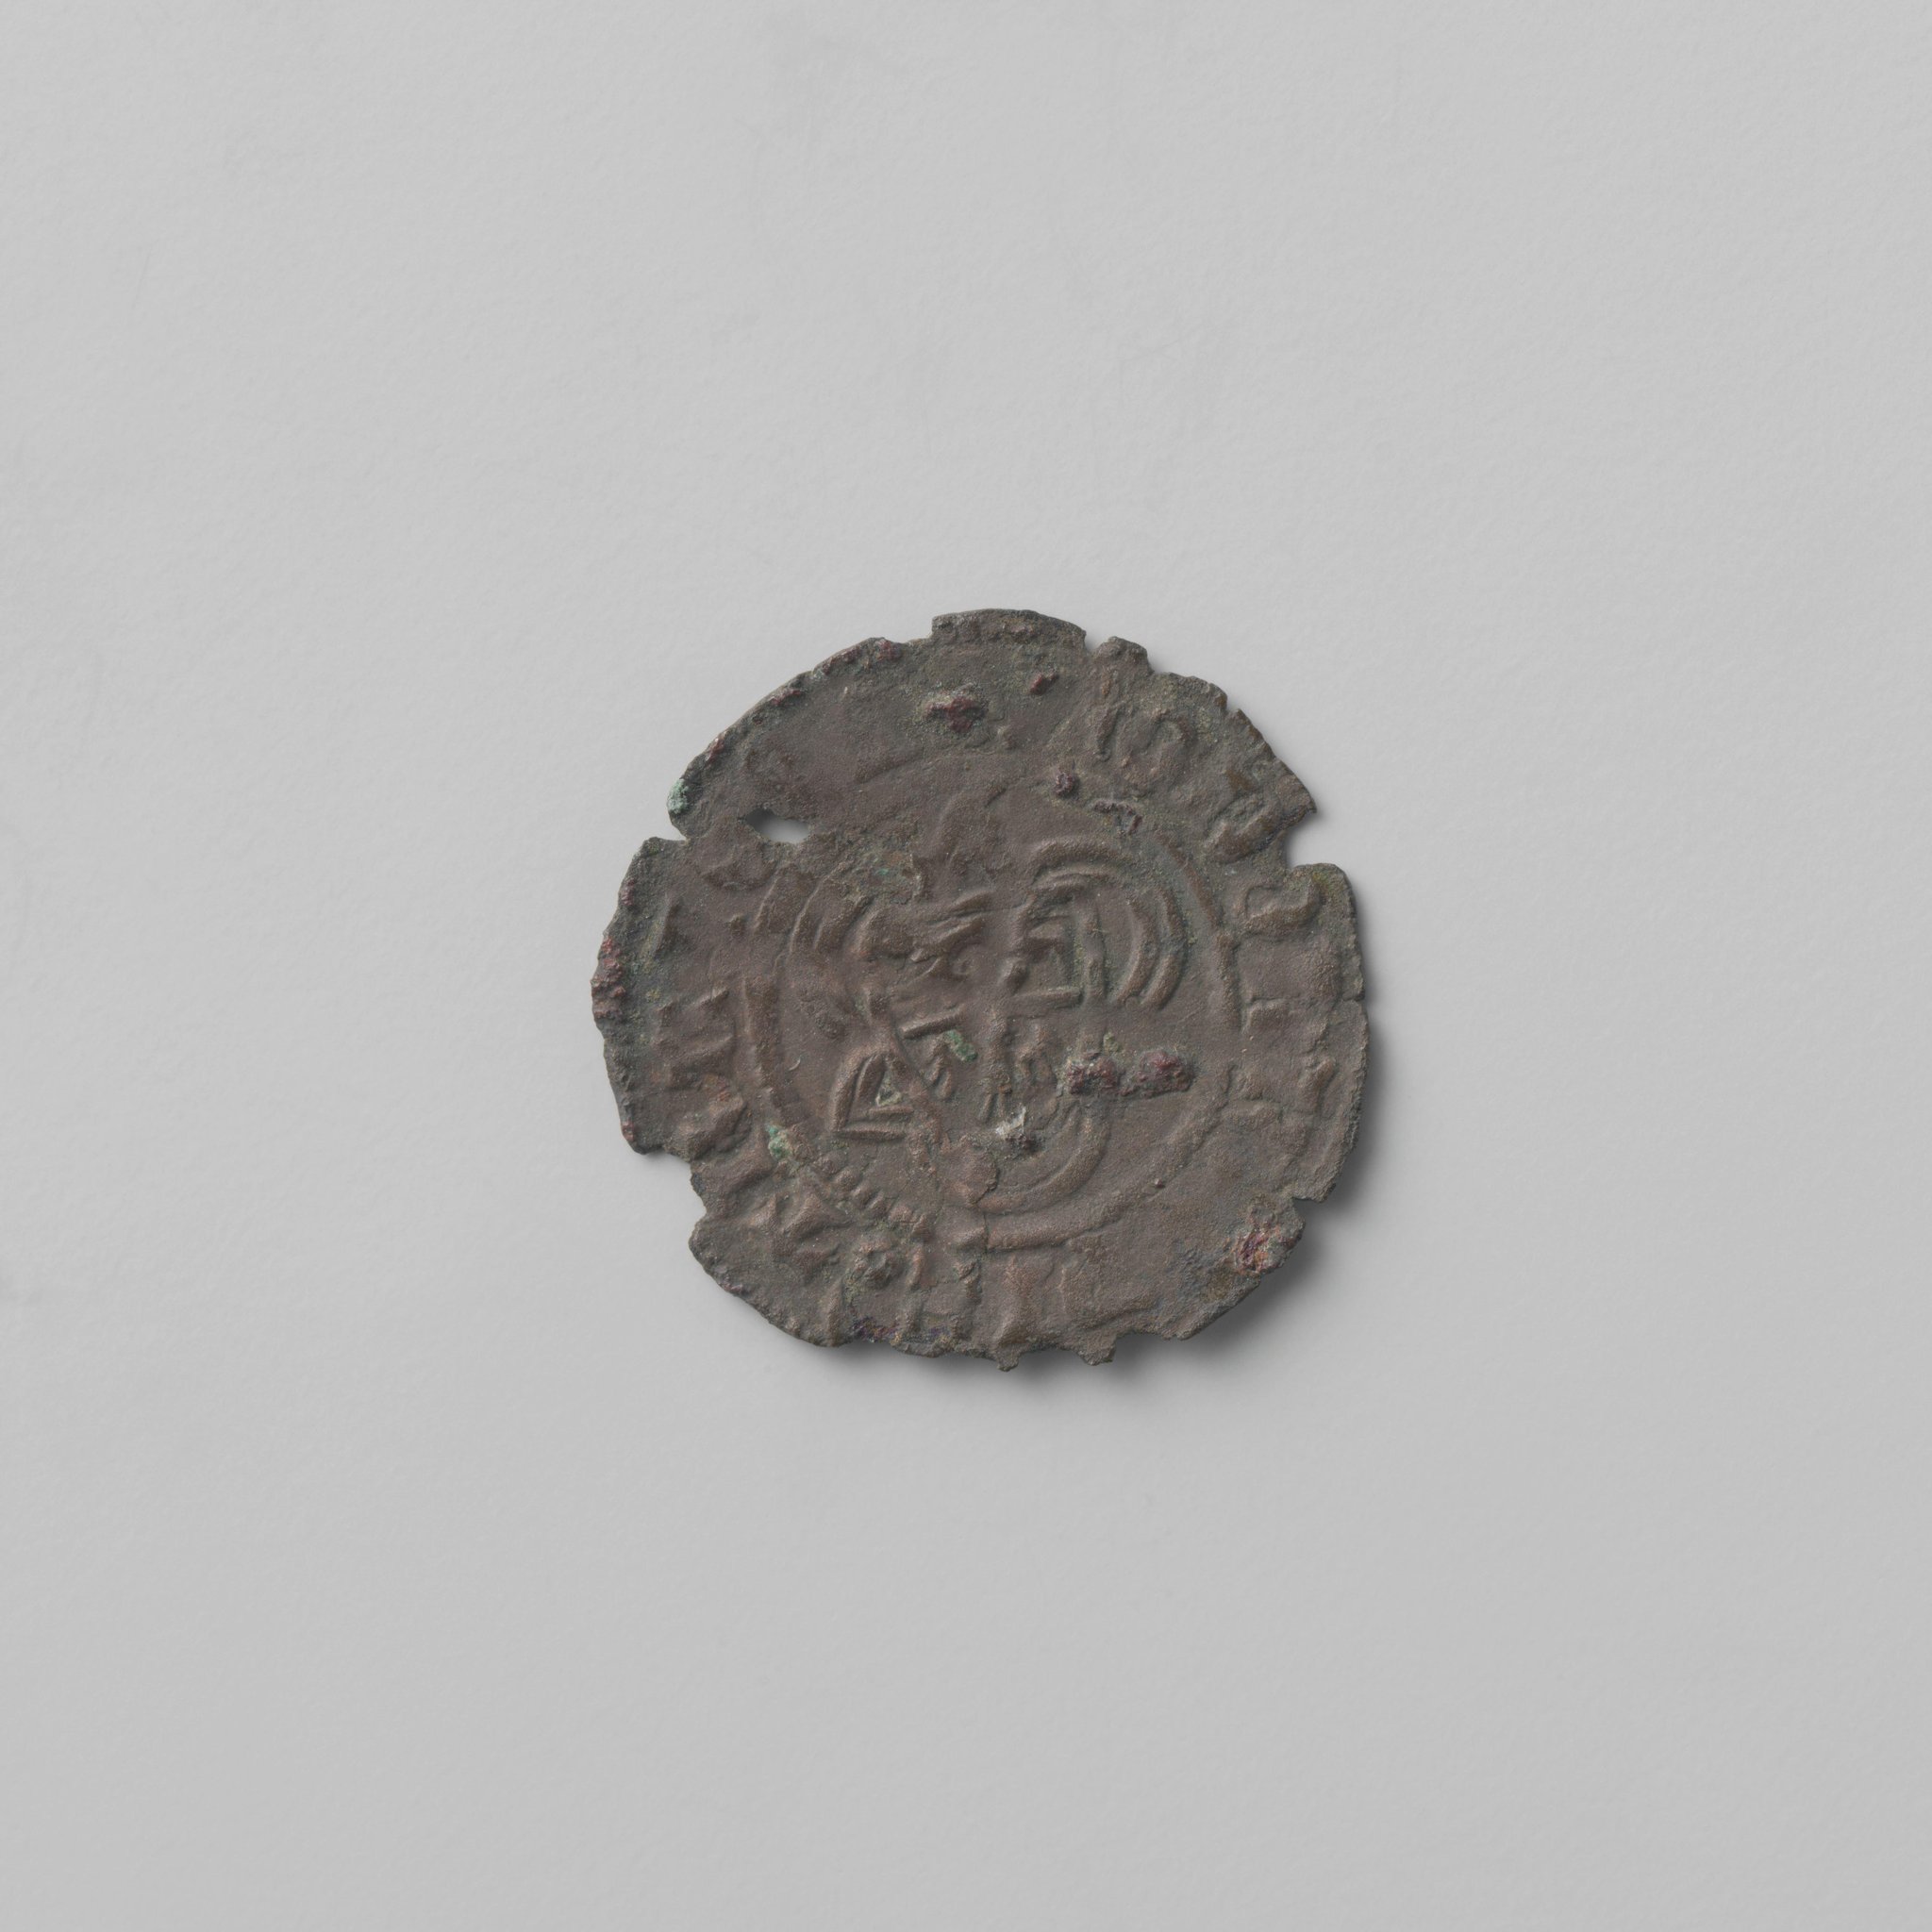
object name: coin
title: Utrechtse groot van Rudolf van Diepholt, 1433-1455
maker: rudolf van diepholt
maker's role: bisschop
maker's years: 1390-1455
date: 1433-1455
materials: silver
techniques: striking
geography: rhenen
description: Zilveren munt. Voorzijde: binnen dubbellijnige driepas wapenschild van Diepholt. Keerzijde: lang gevoet kruis met in de hoeken R, O, D en F. Omschrift: MON-ETA-REN-ESIS